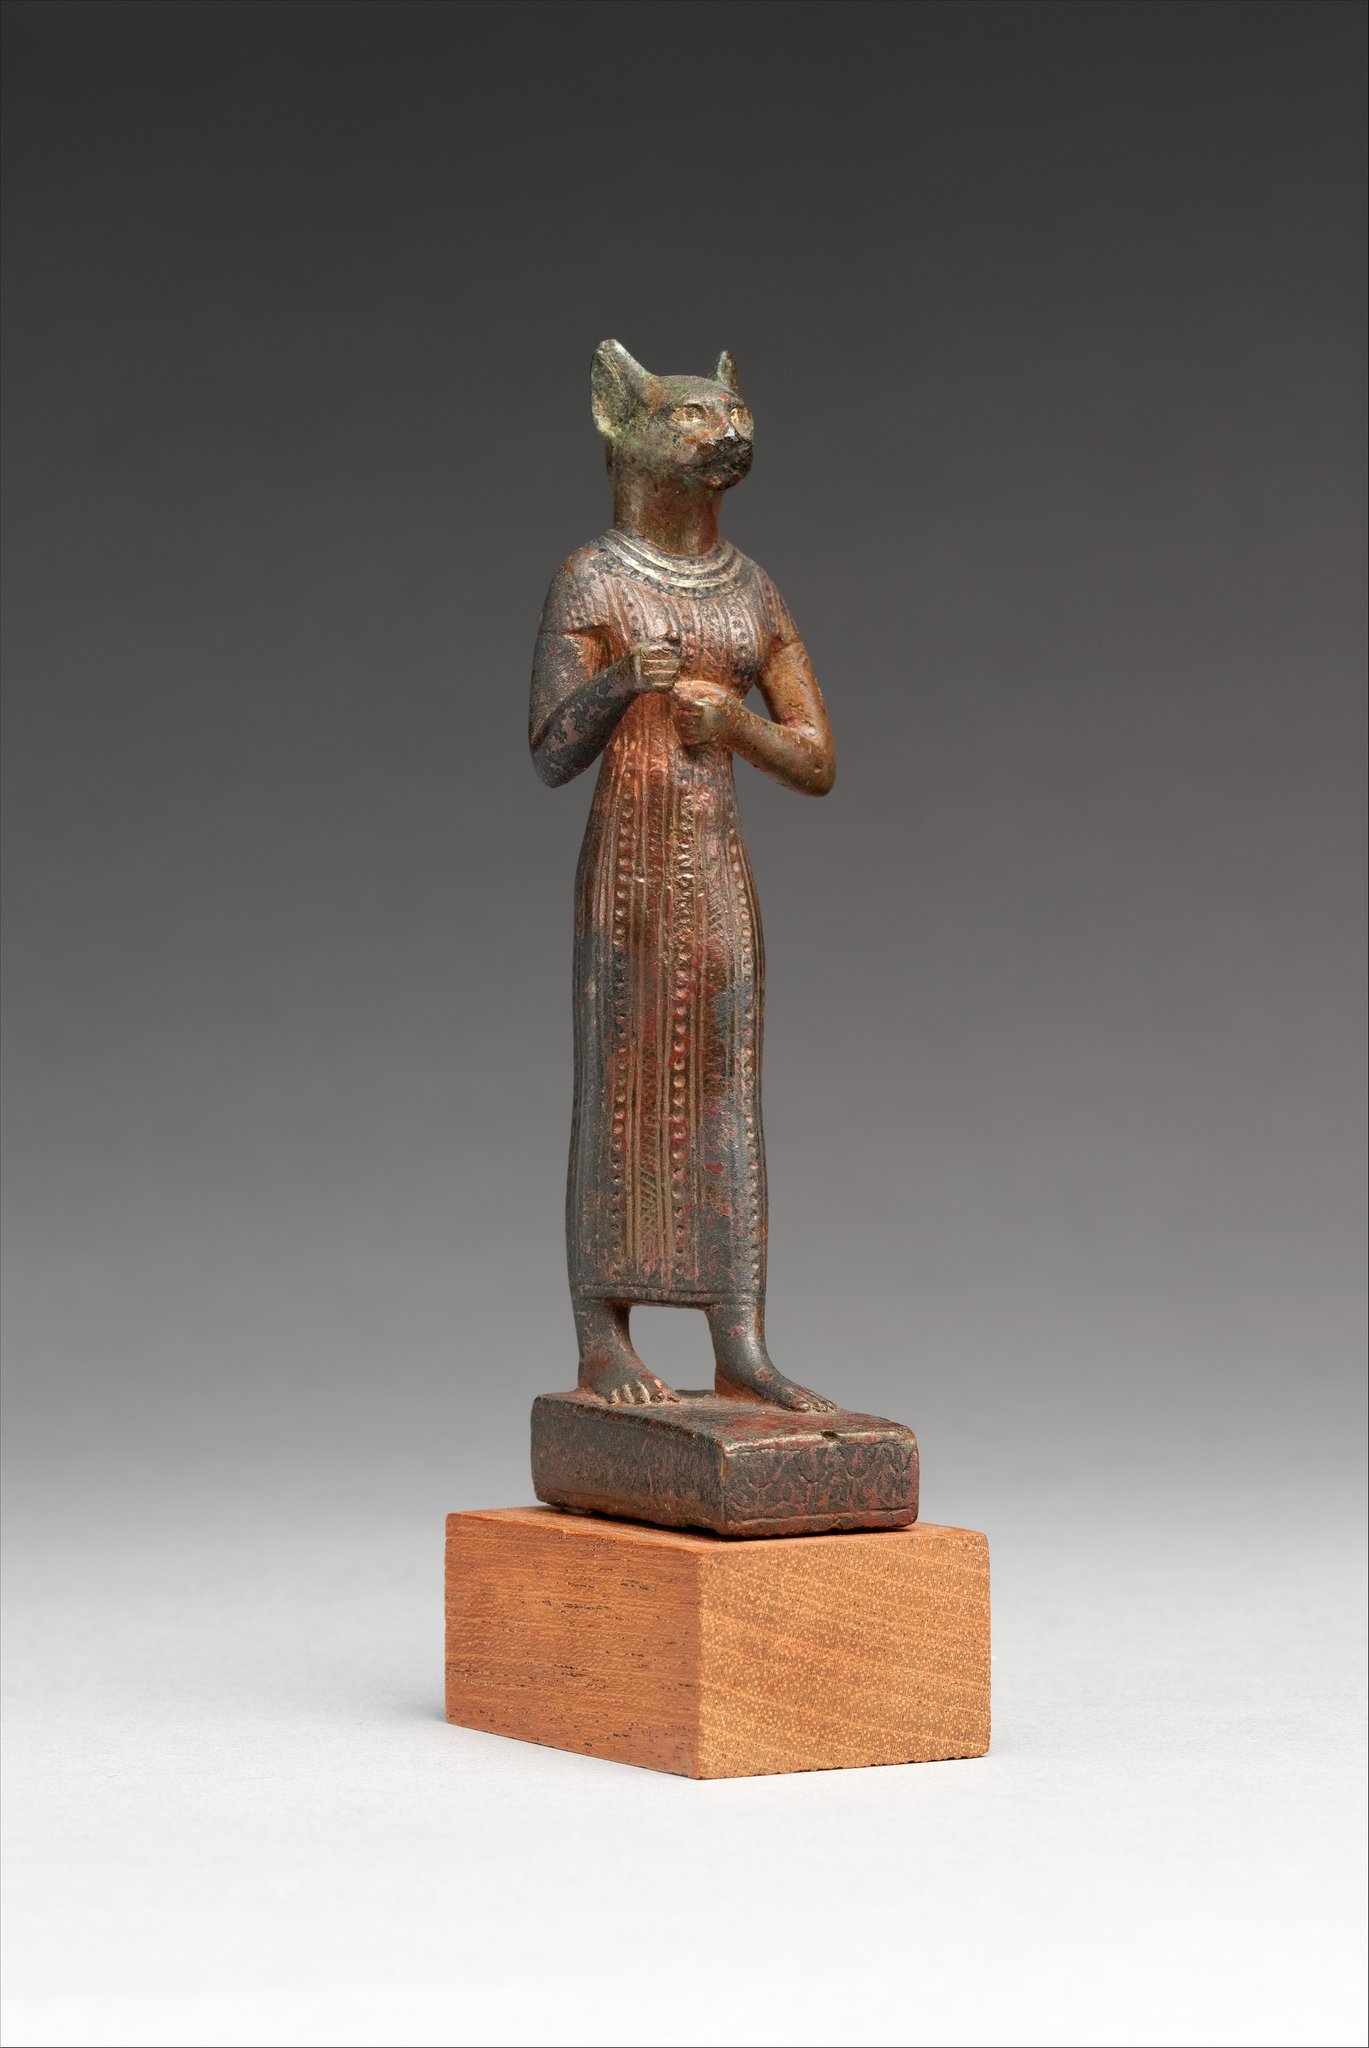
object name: figure, bastet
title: Bastet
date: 664-630 BCE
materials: bronze, metal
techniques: inlay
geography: egypt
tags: goddess